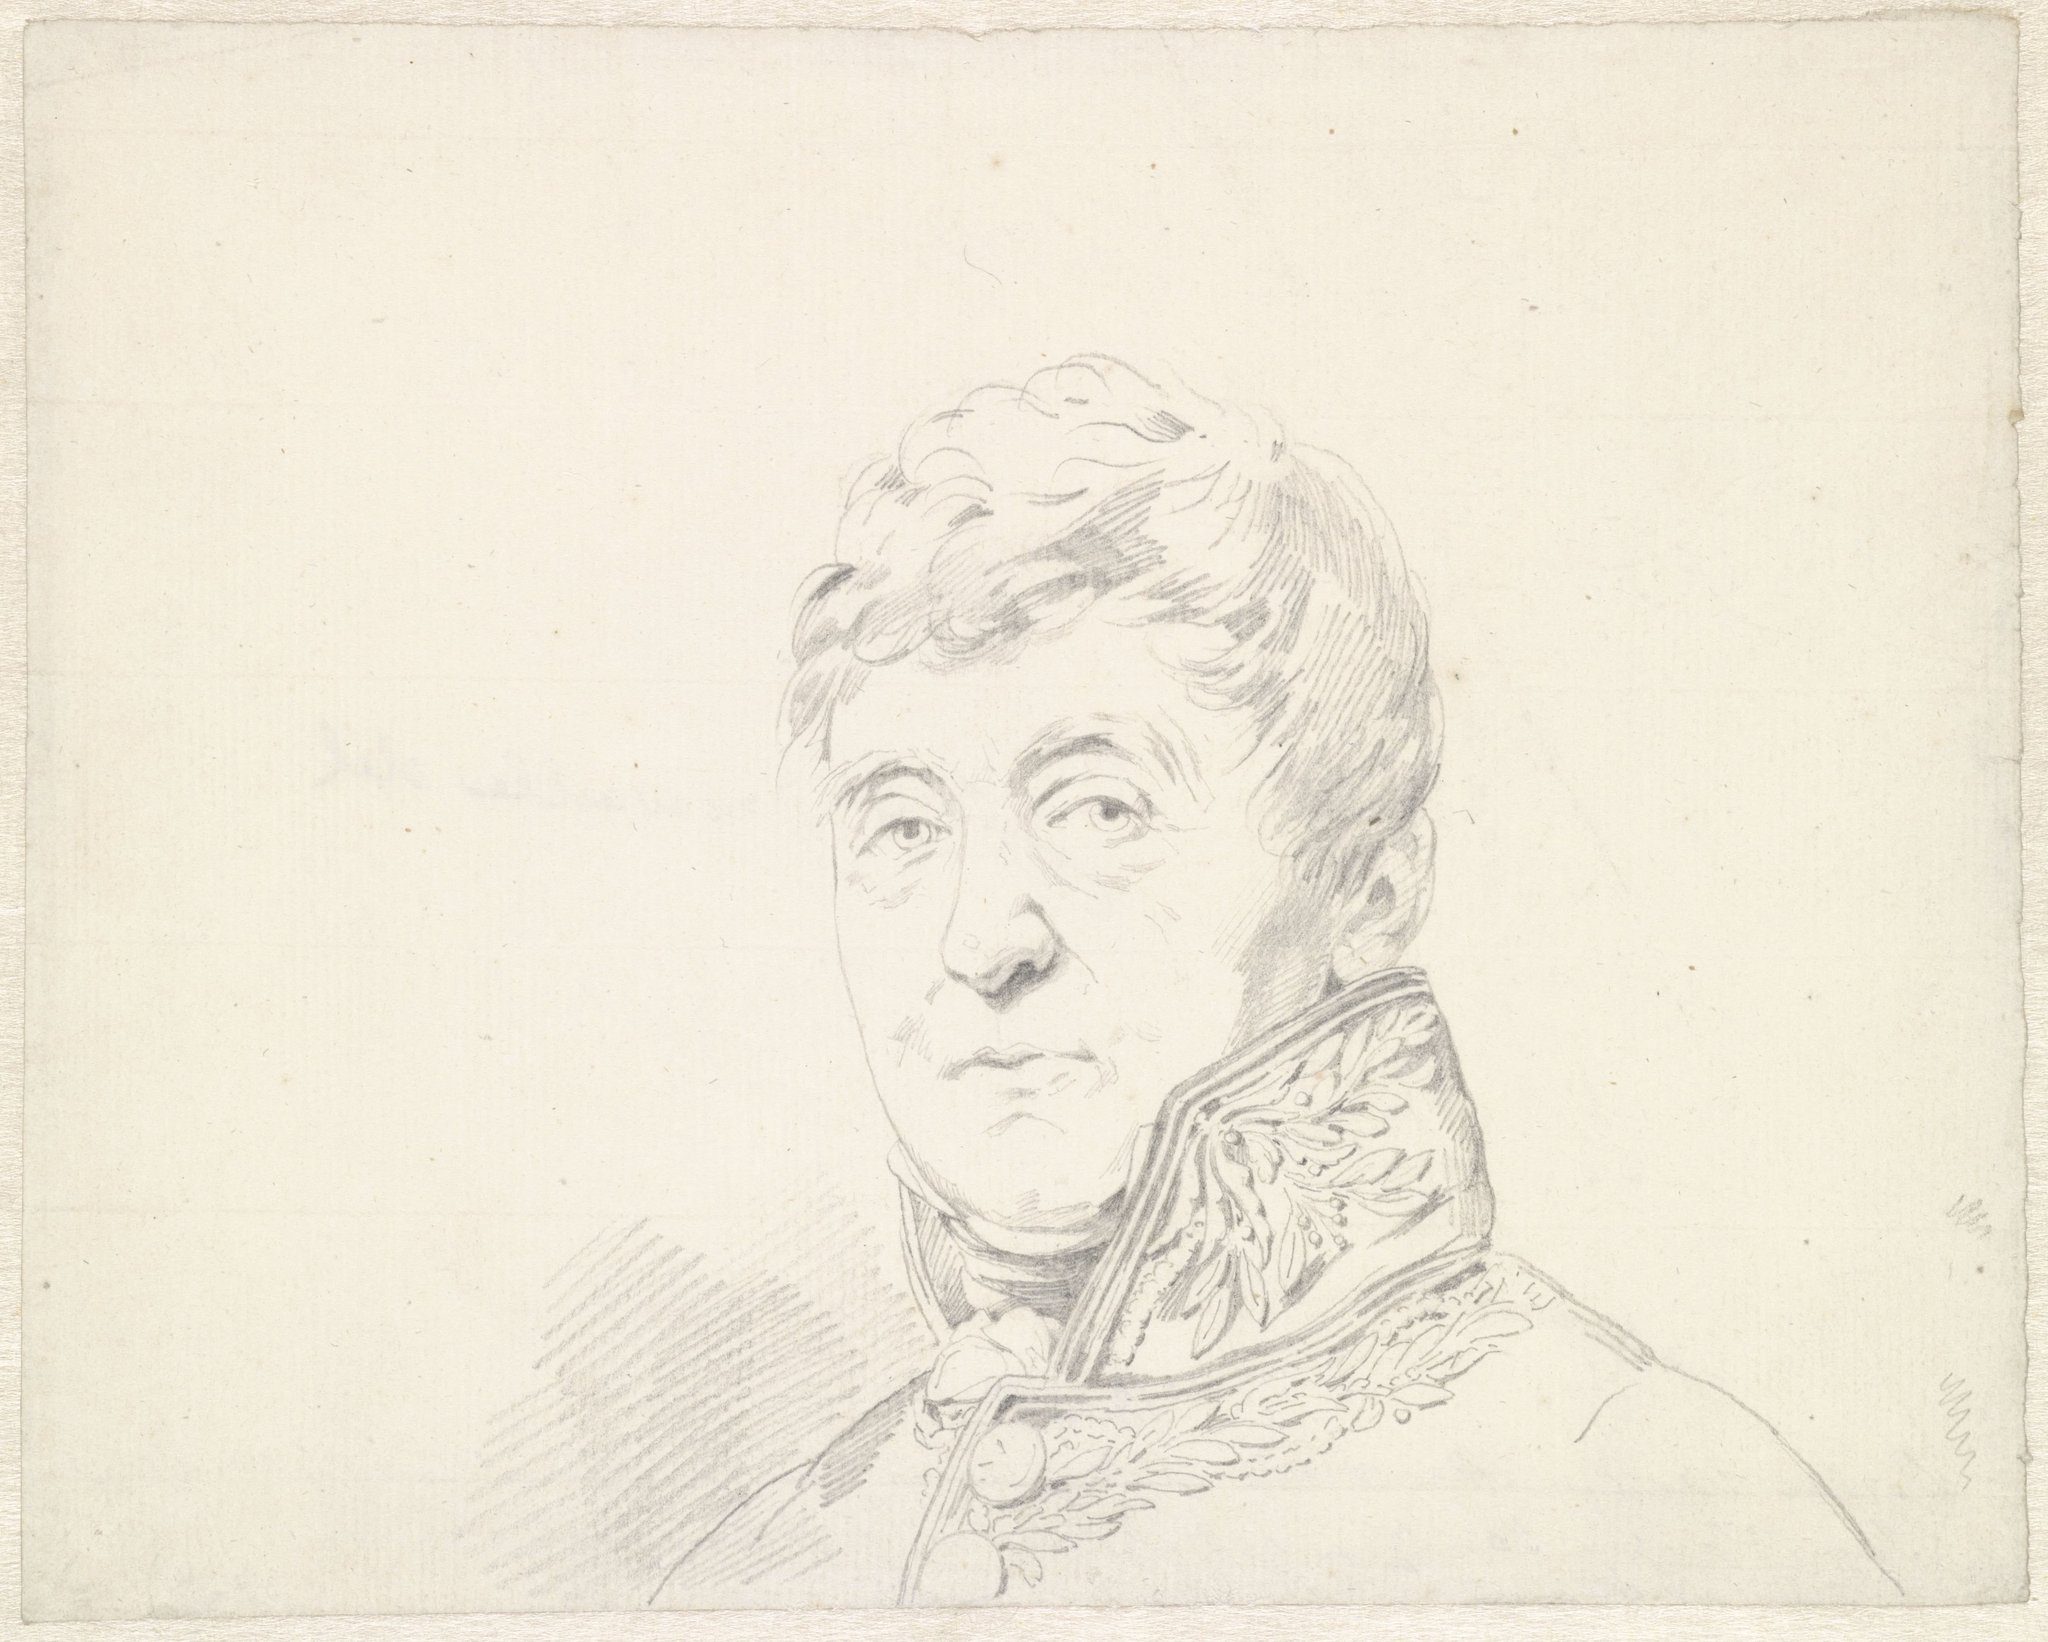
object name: drawing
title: Portret van Jan Blanken Jansz.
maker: jean augustin daiwaille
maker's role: draughtsman, print maker, printer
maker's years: 1786-1850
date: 1823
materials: paper, pencil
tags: jan blanken jansz., historical persons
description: De tekening is een voorstudie voor het geschilderde portret van Daiwaille.